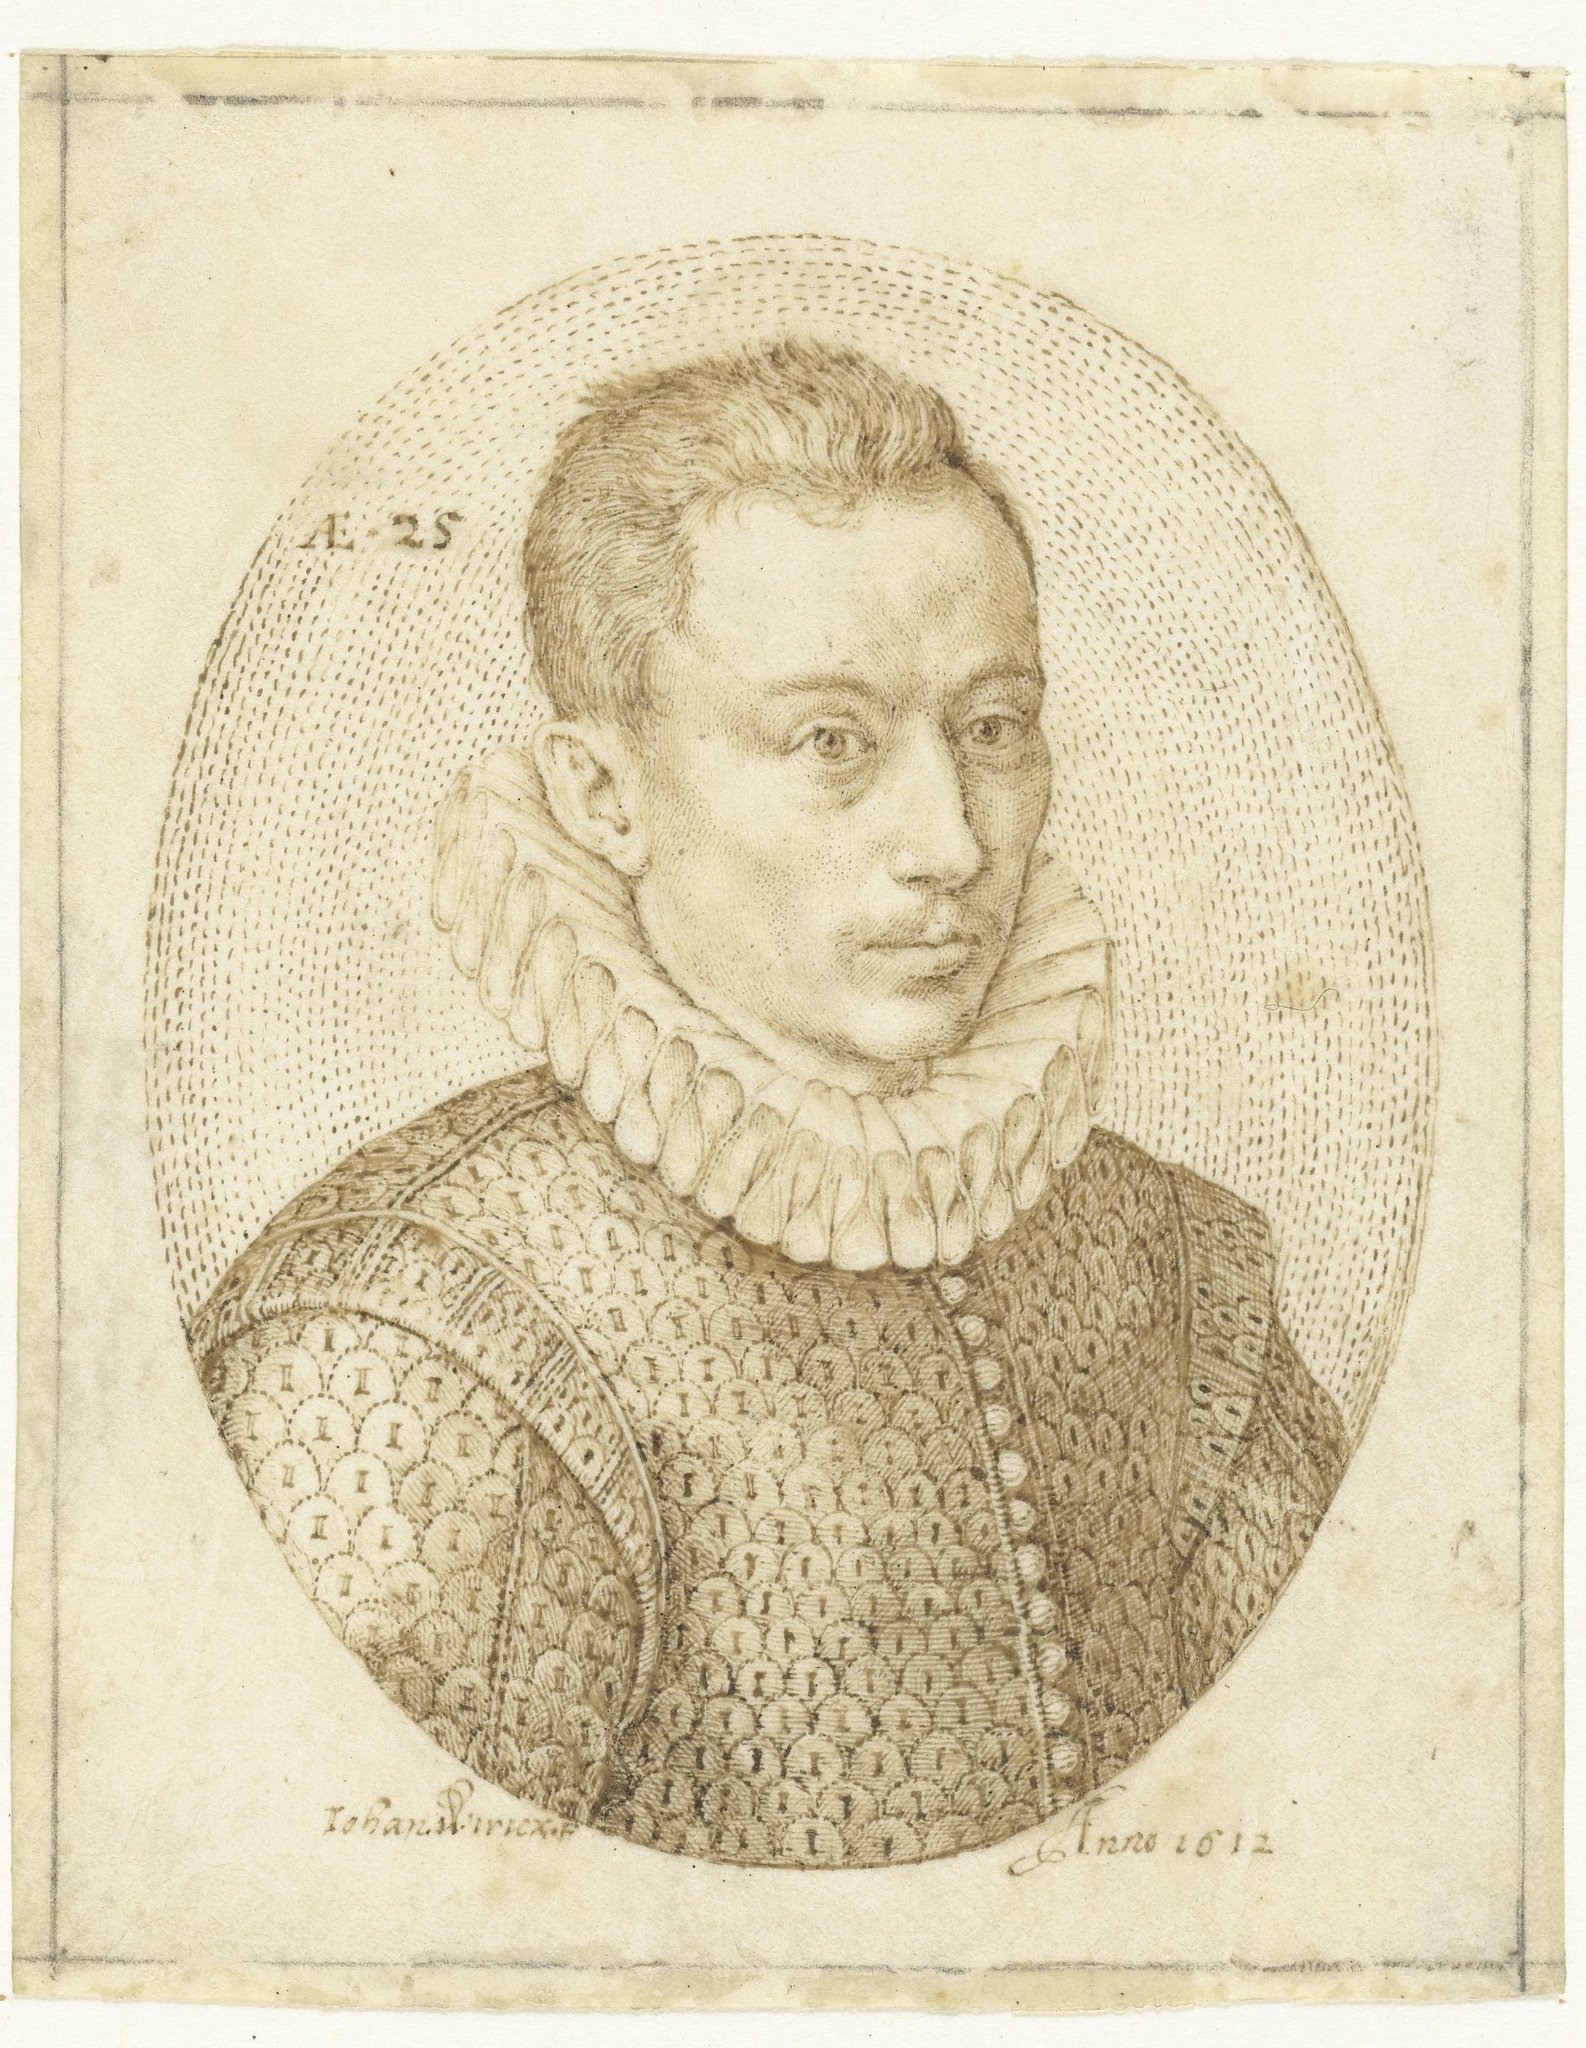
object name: drawing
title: Portret van een onbekende man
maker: johannes wierix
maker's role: draughtsman, print maker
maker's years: 1549-1618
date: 1612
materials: ink, parchment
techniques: pen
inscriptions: date